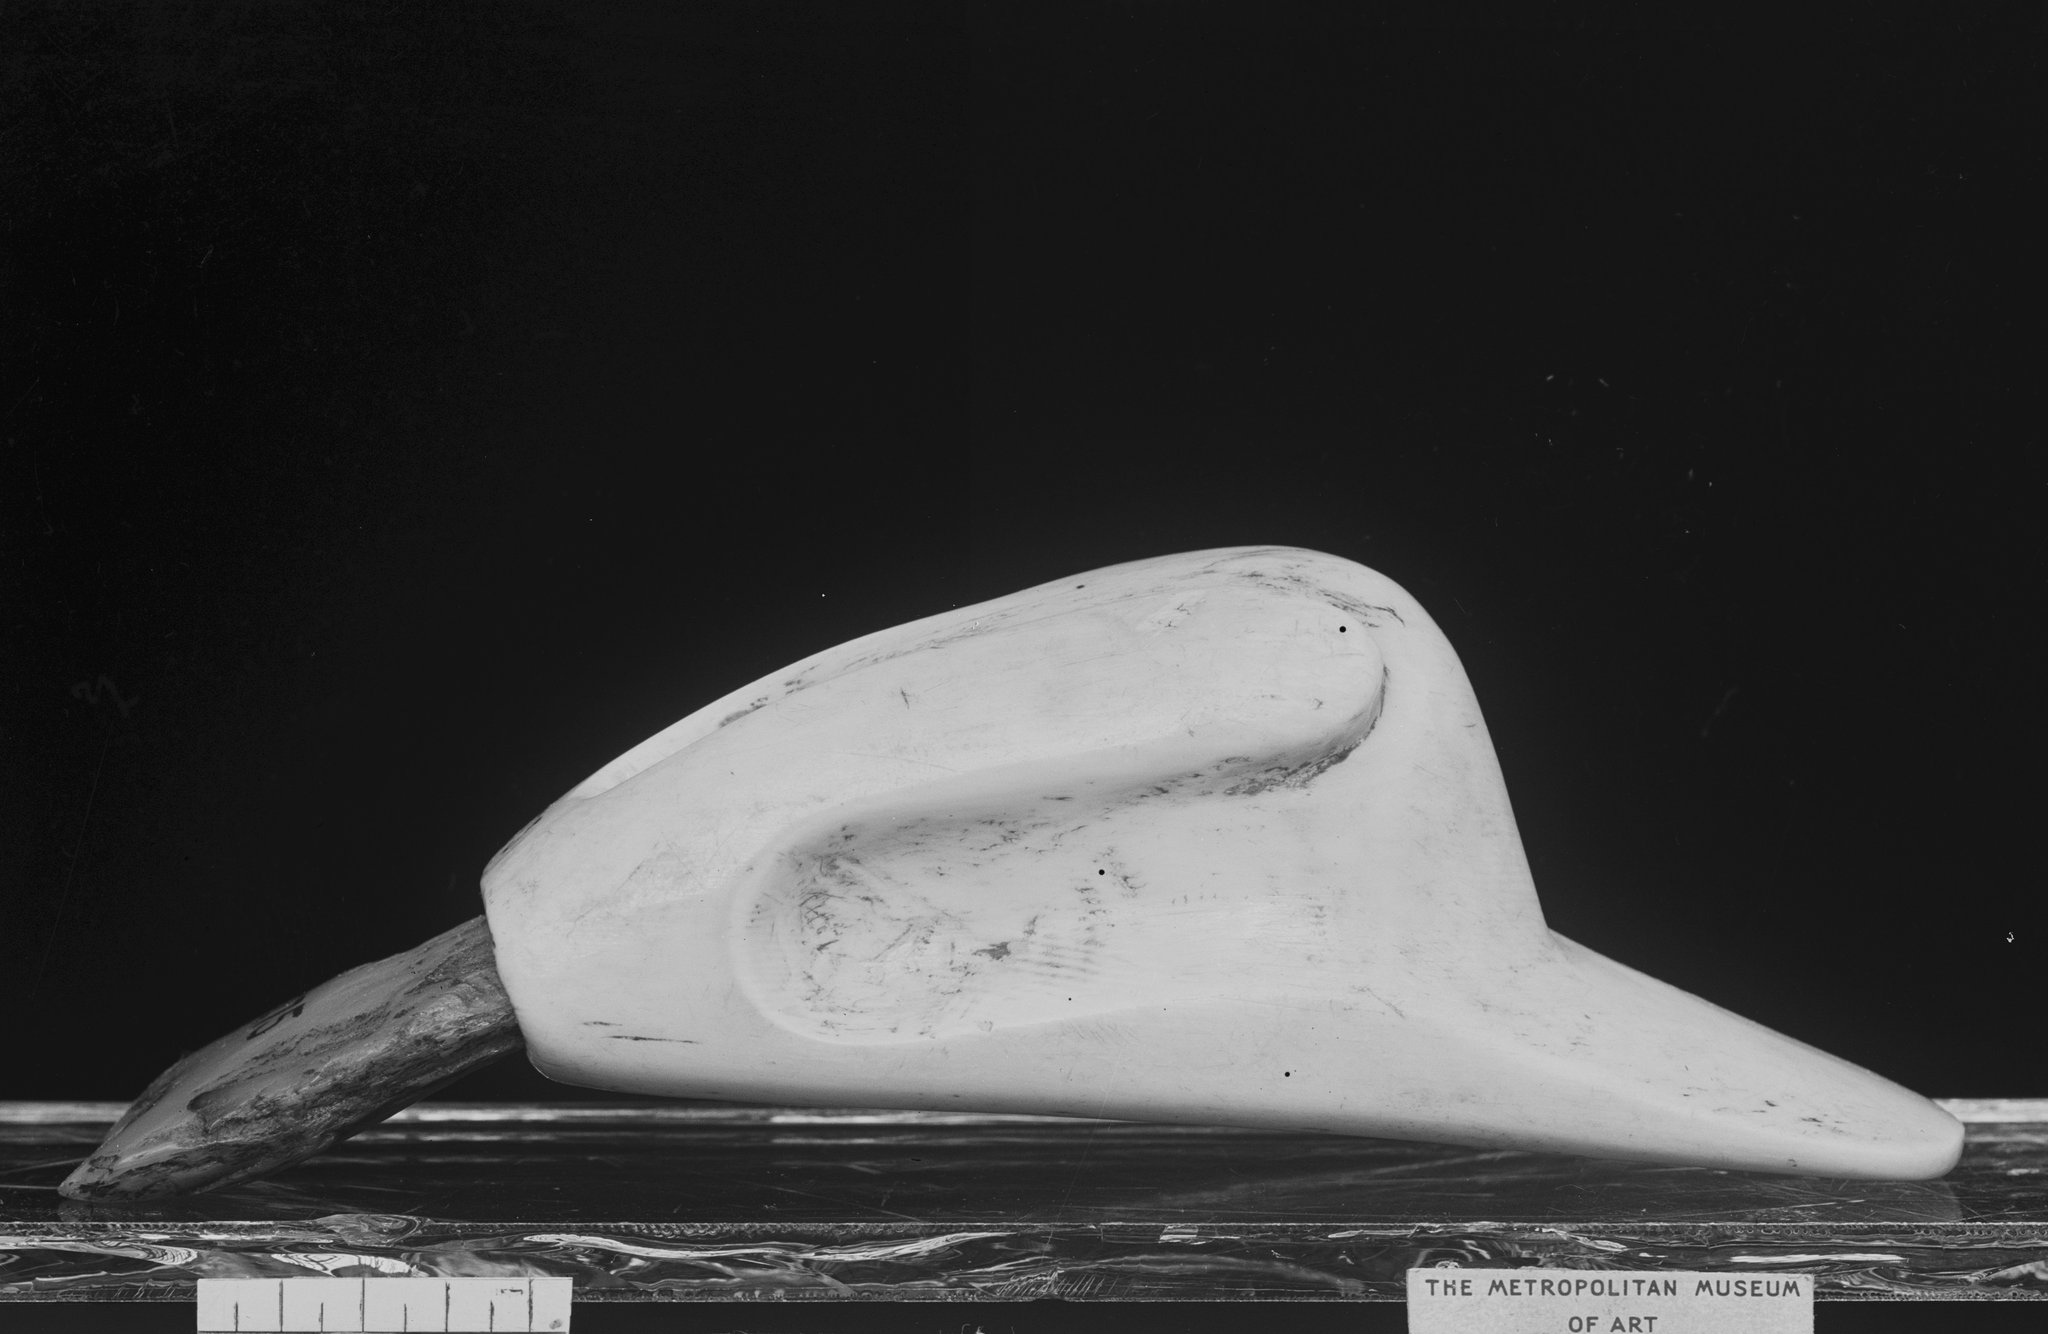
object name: scraper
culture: north american, alaskan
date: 1902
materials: jade